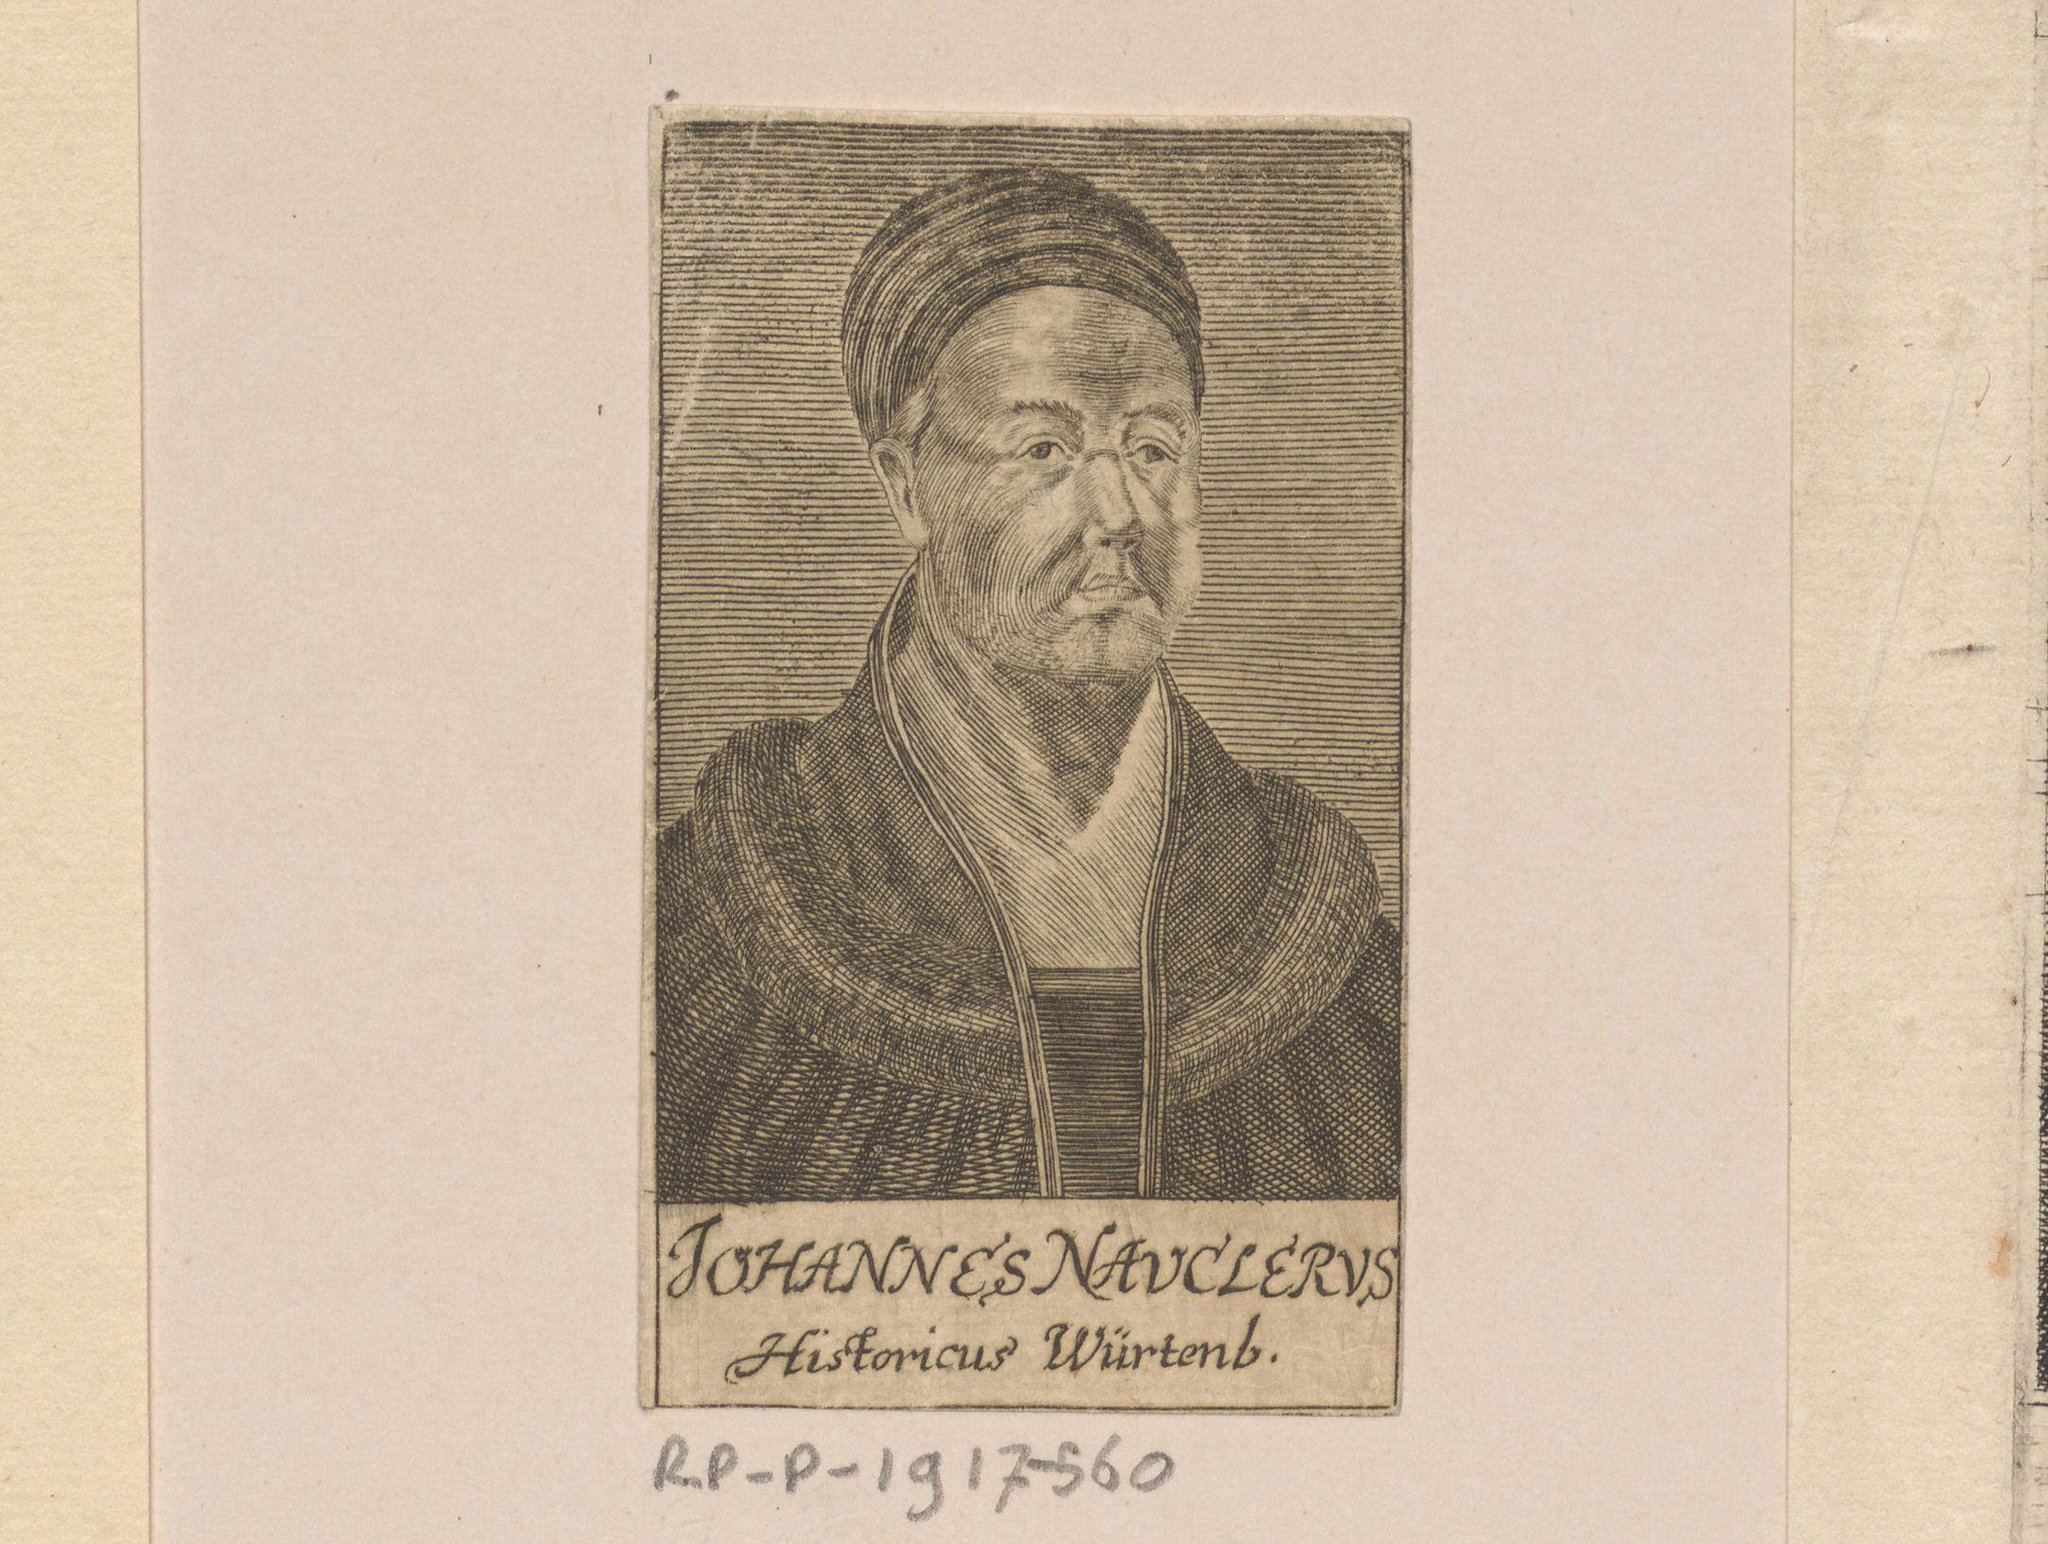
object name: print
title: Portret van Johannes Nauclerus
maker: Anonymous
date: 1688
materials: paper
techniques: engraving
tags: historical persons, portrait of a writer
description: Prent maakt deel uit van een grotere prent die later is verknipt. Prent waarschijnlijk uit: Freher, Paul. Theatrum virorum eruditione clarorum. Neurenberg: Johann Hoffmann, 1688.